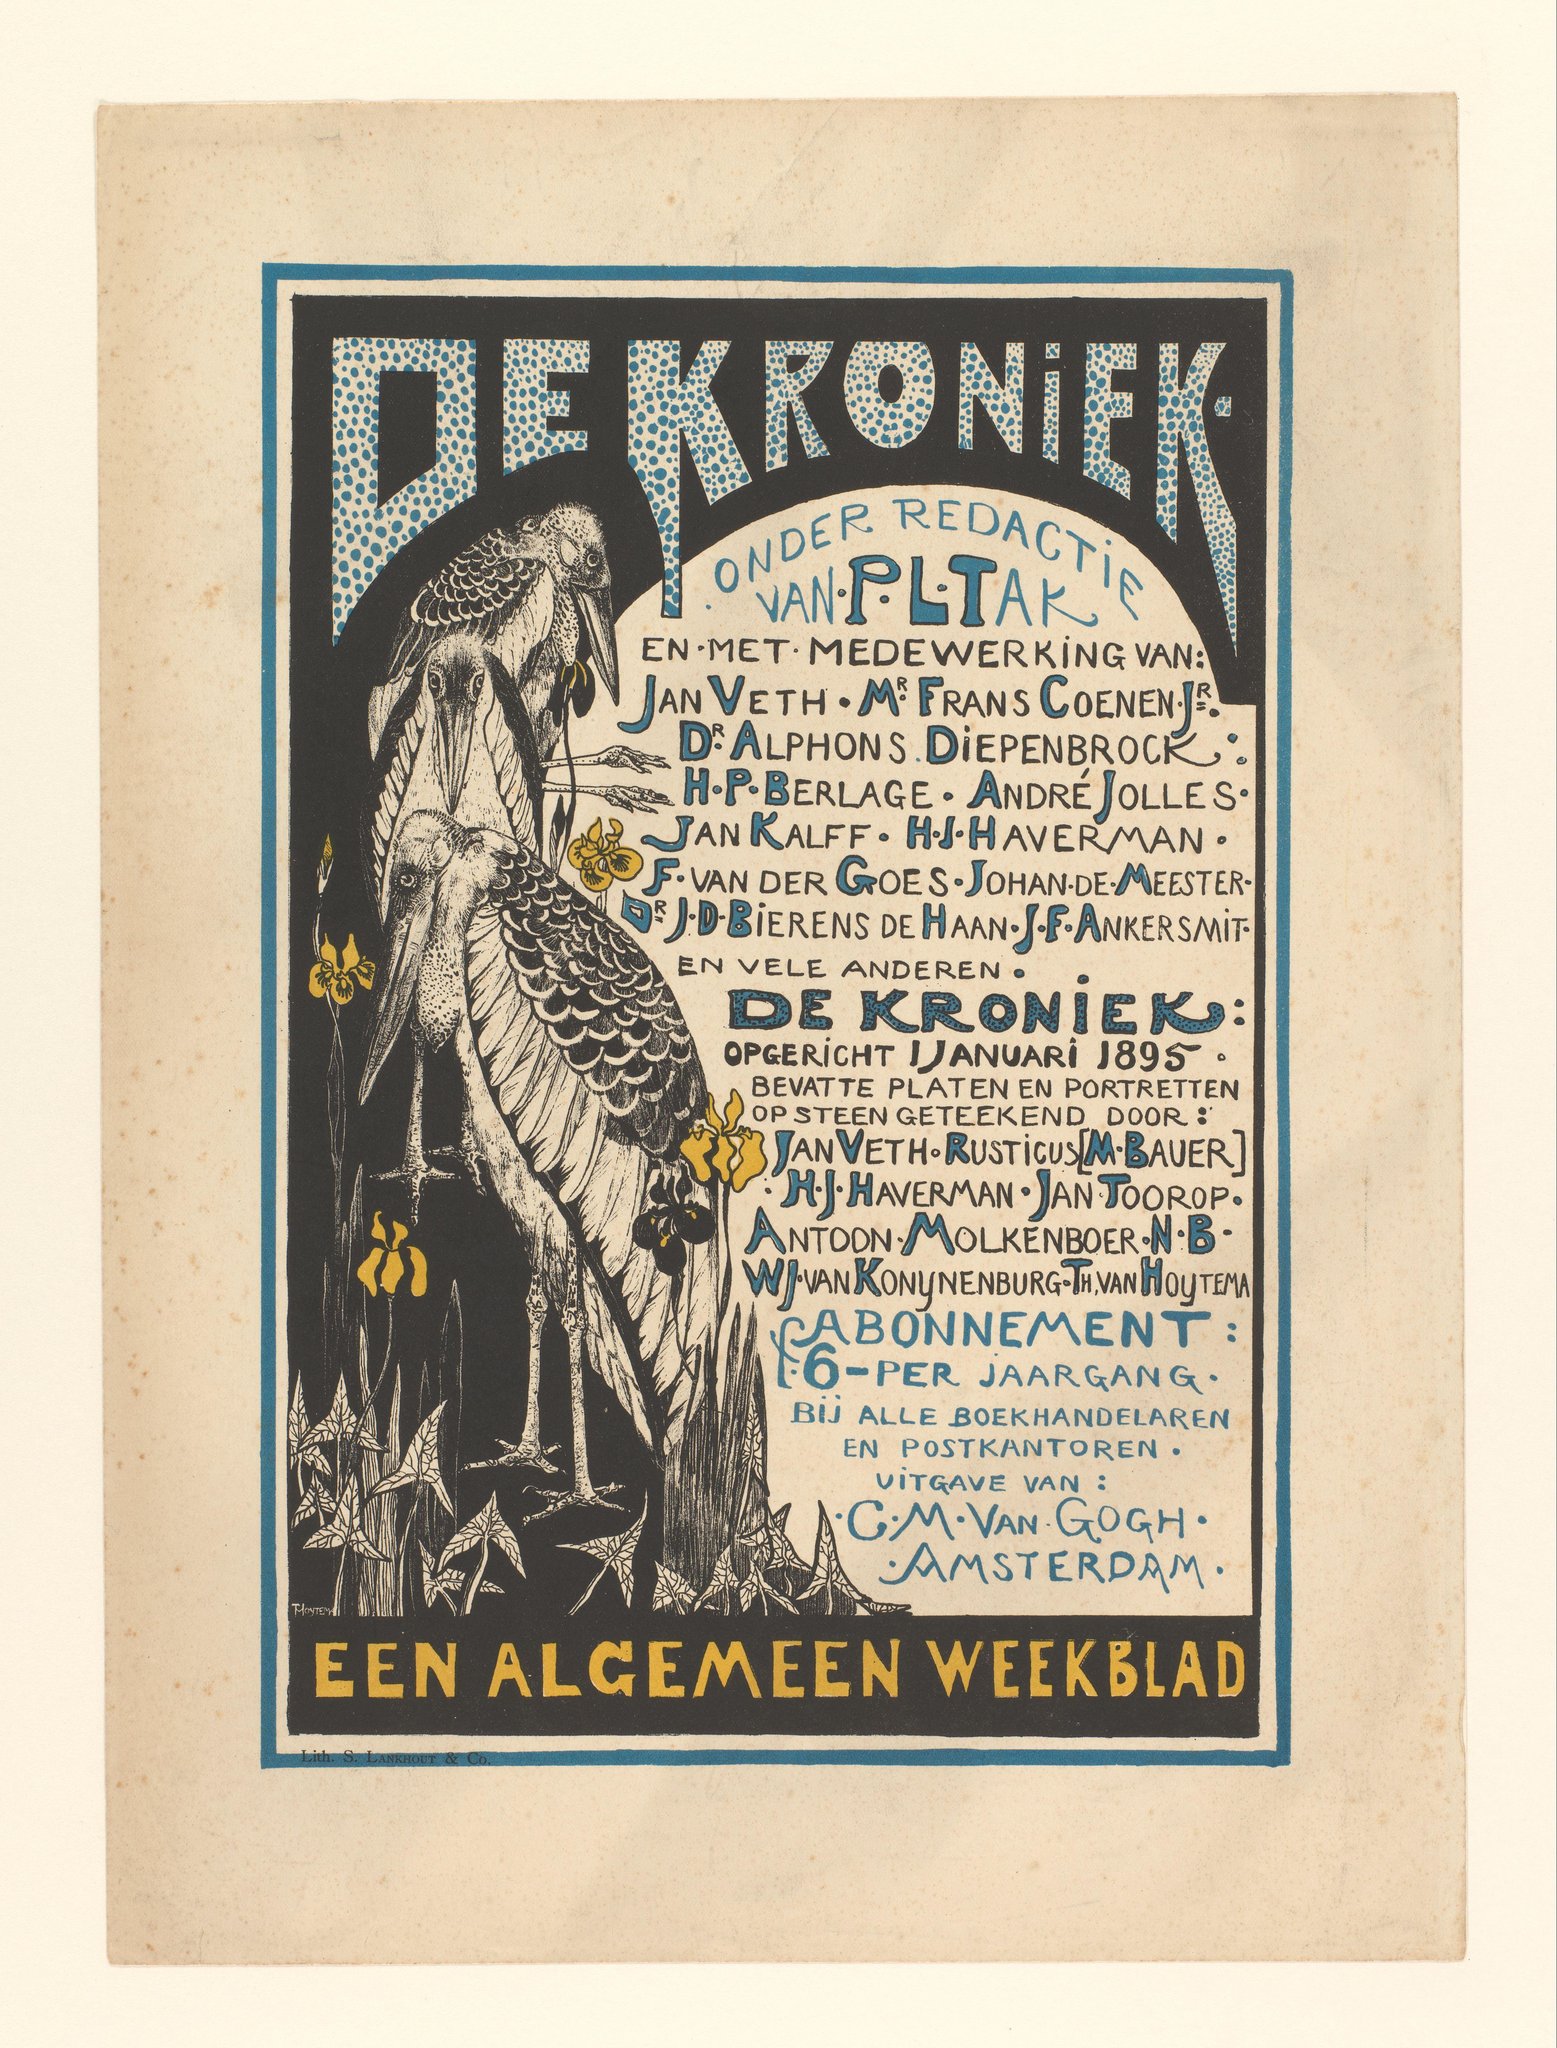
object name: poster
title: Affiche ter aankondiging van het tijdschrift 'De kroniek'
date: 1895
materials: paper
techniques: lithograph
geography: amsterdam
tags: birds, flowers: lily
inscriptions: collector's mark: Lugt 2228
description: Affiche ter promotie van: Tak, P.L. (red.). De kroniek, een algemeen weekblad. Amstserdam: C.M. van Gogh, 1895.